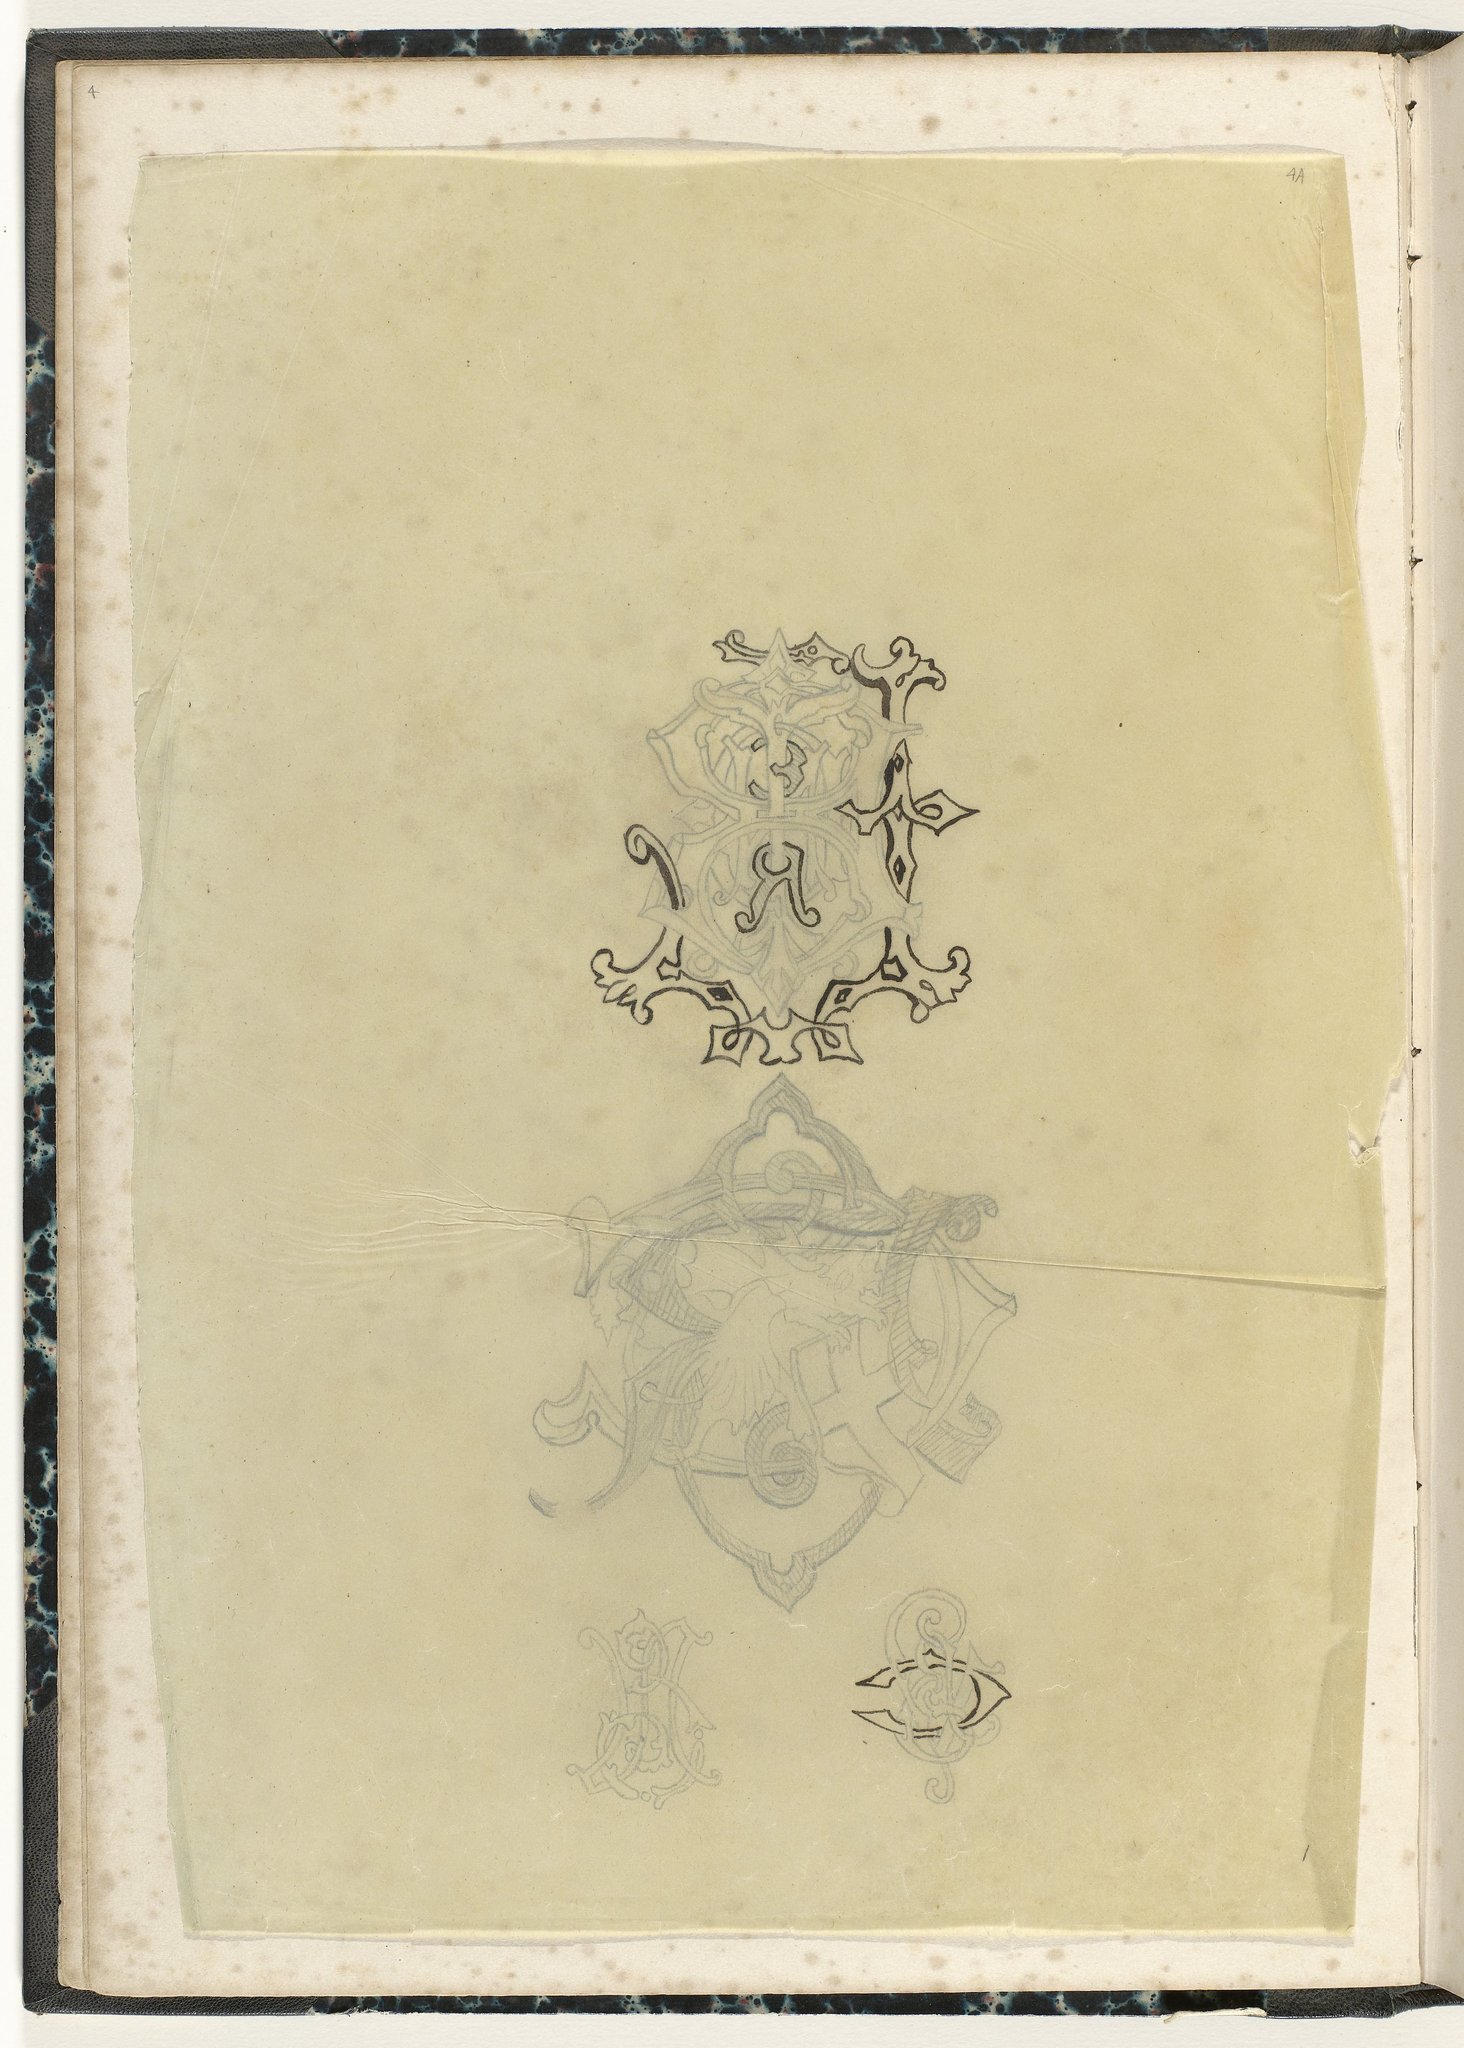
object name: drawing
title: Vier monogrammen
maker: Anonymous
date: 1866-1900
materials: ink, pencil, paper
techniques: drawing